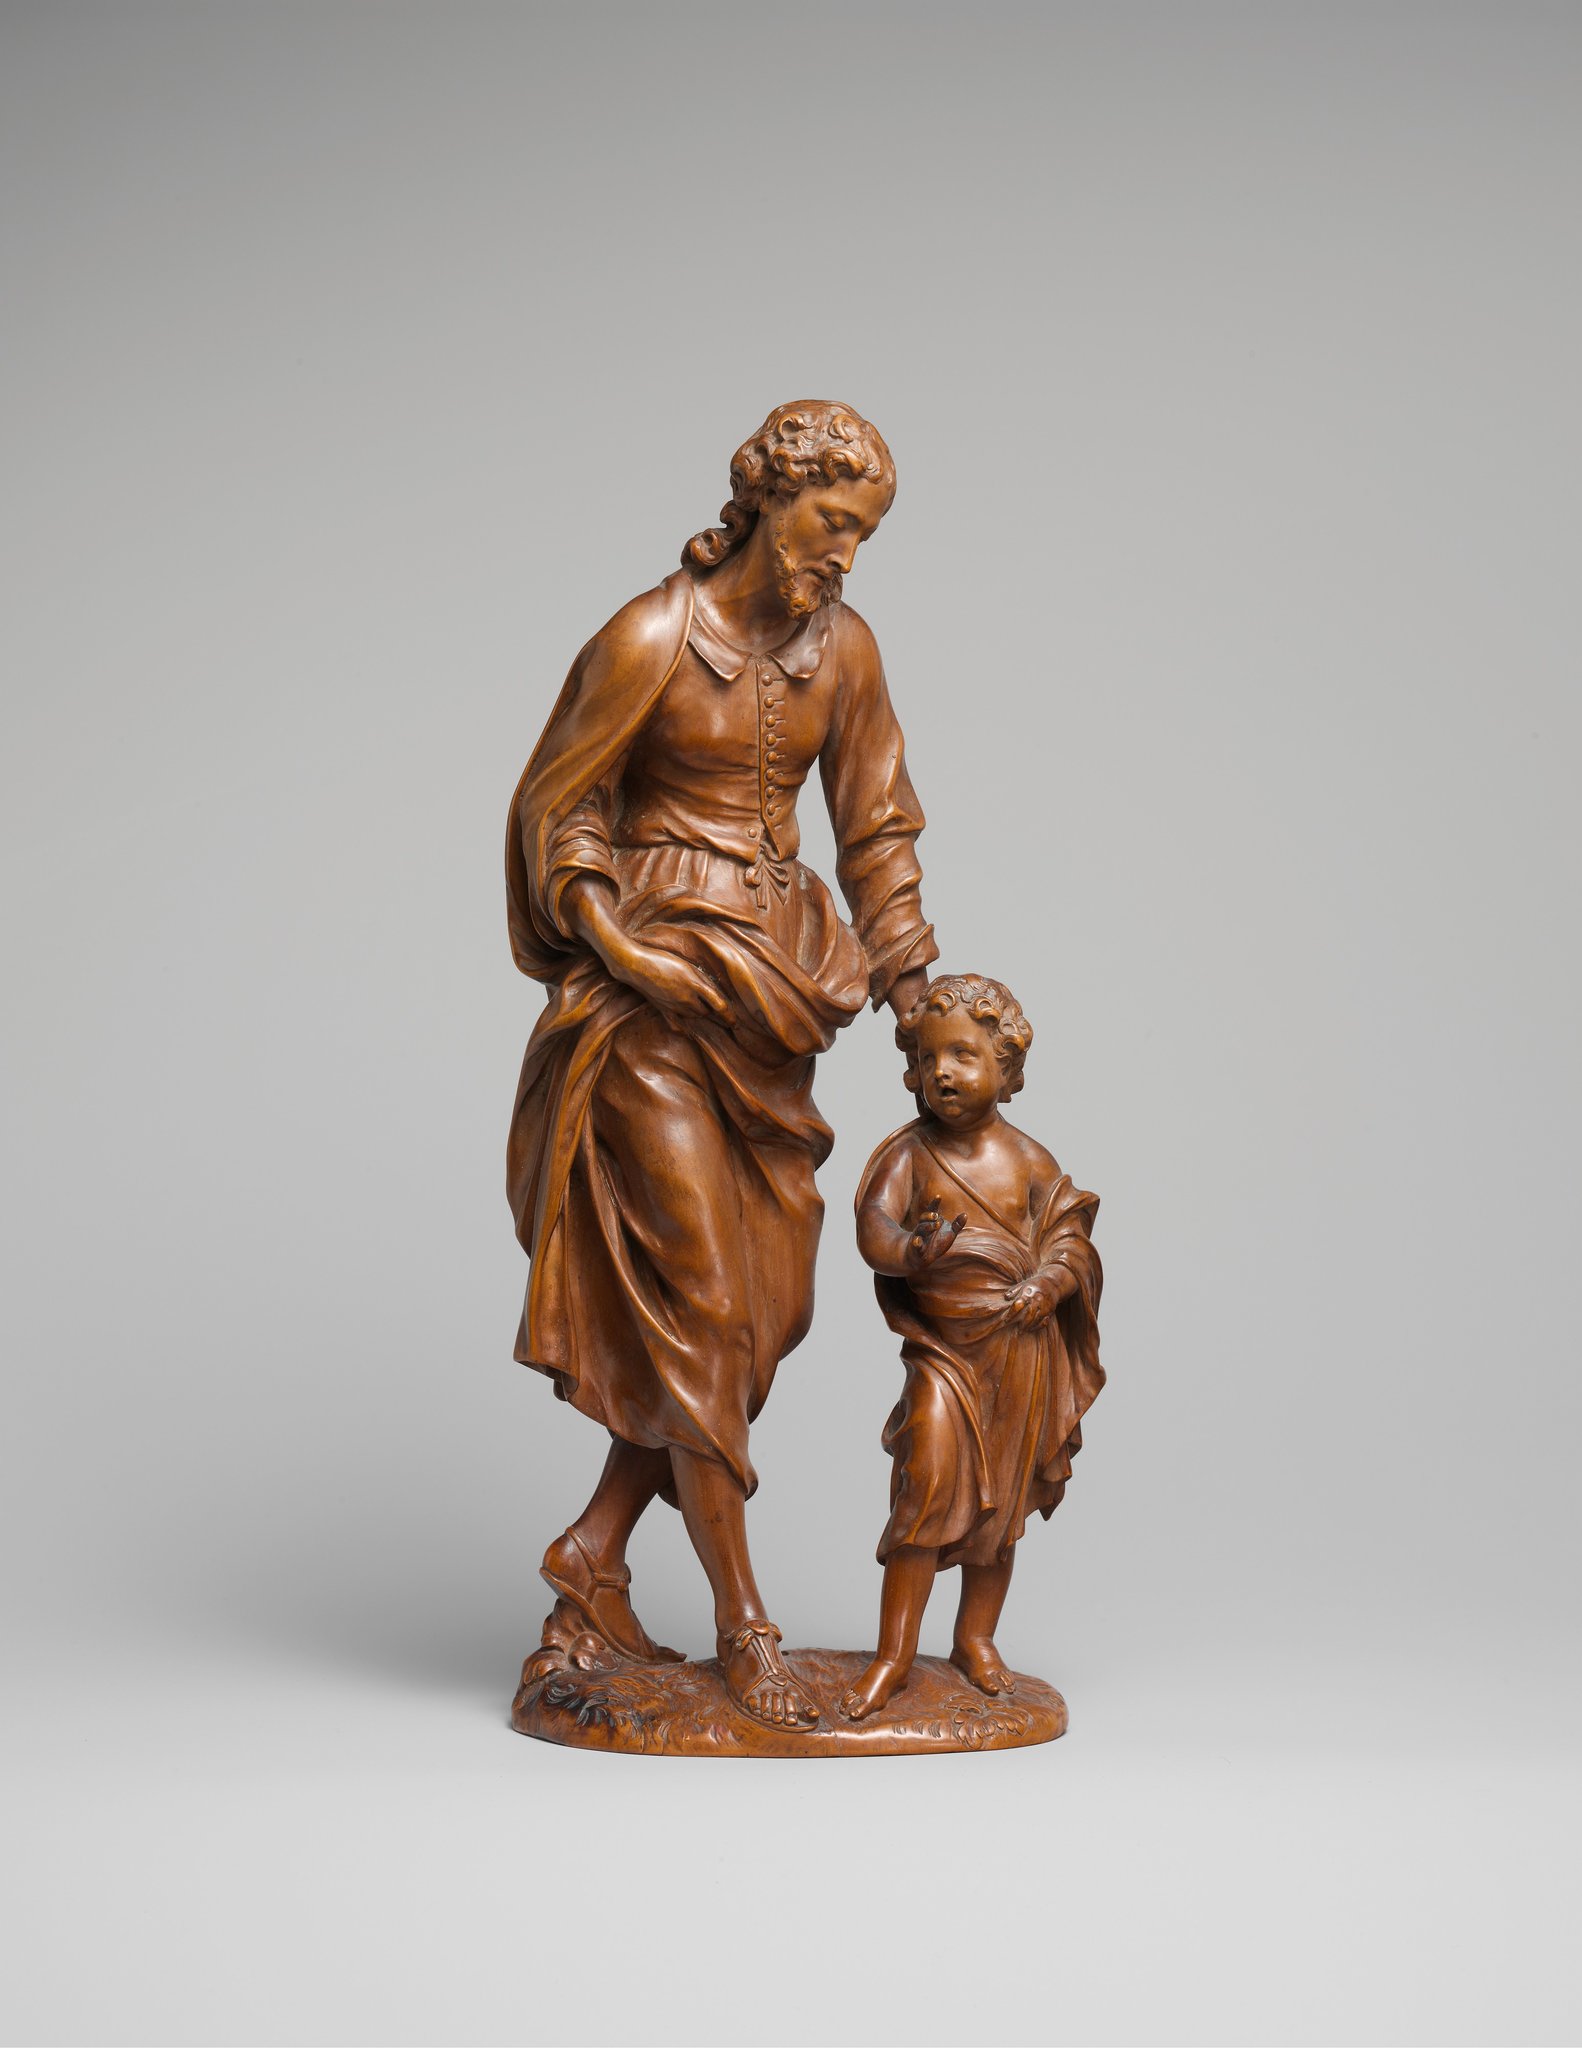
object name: statuette group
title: Saint Joseph and the Christ Child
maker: nicolaas van der veken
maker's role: artist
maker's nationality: flemish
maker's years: 1637-1709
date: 1651-1700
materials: wood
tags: christ,saint joseph